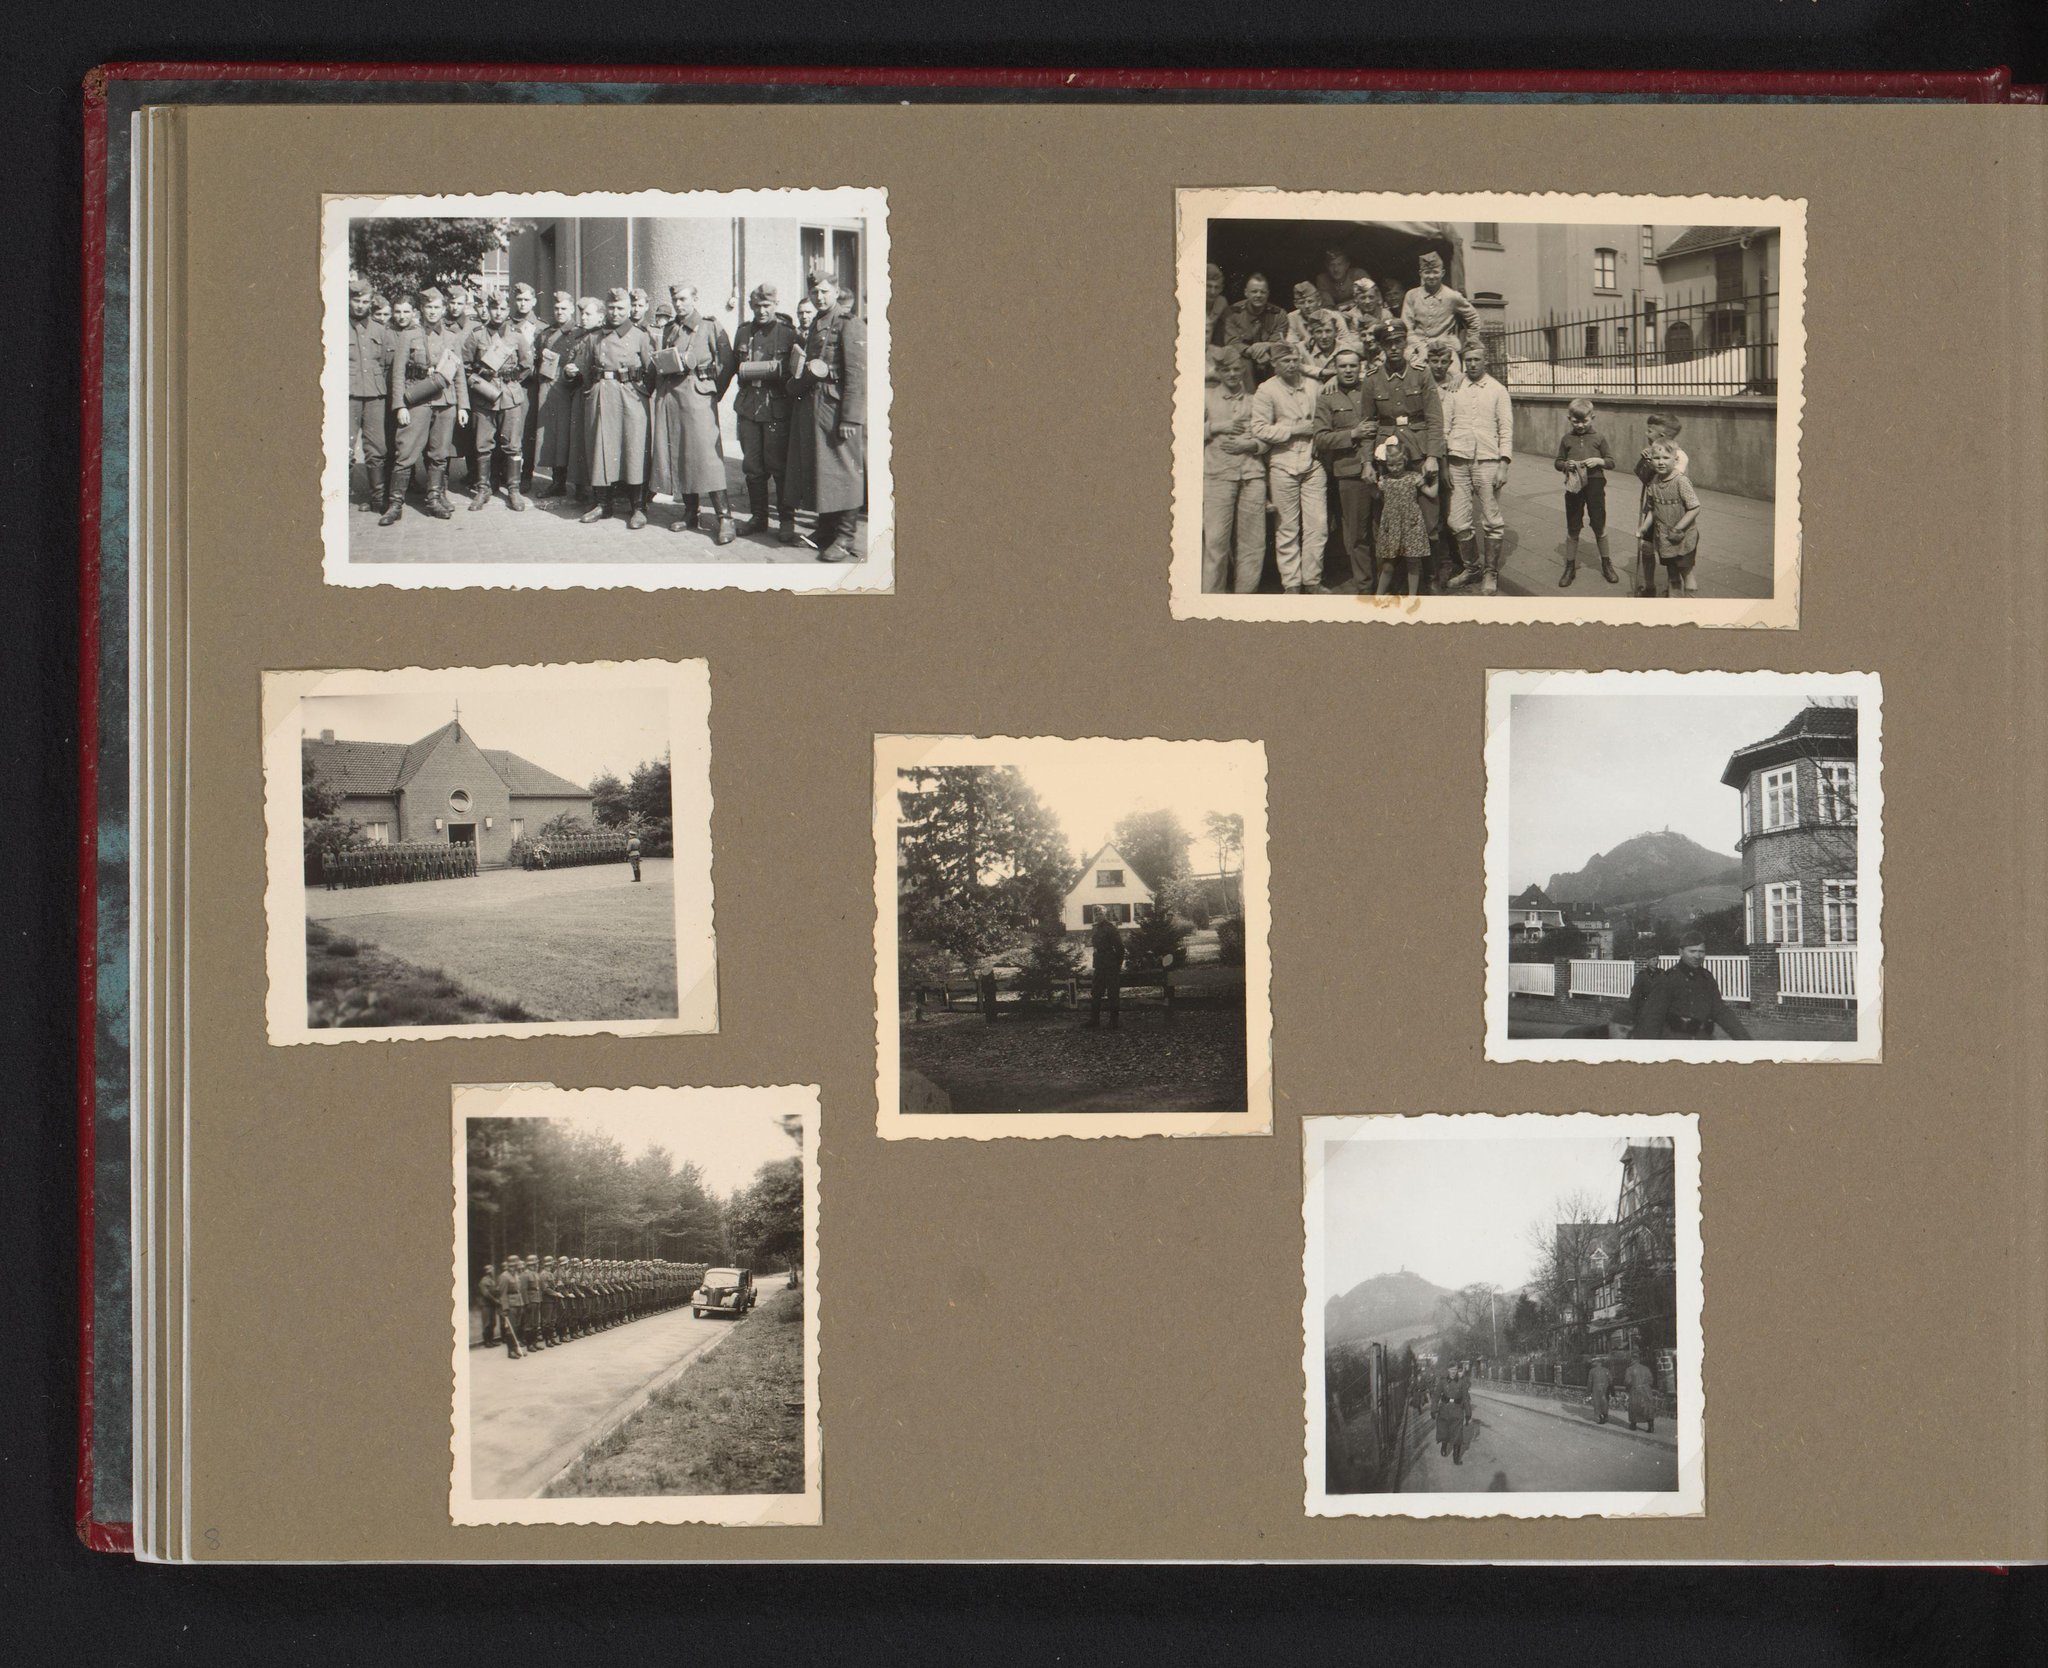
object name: photograph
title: Diverse onderwerpen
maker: Anonymous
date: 1939-1943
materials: paper, photographic support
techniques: gelatin silver print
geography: germany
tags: the company, the unit, the troop ~ military service, review, inspection (of company, unit, troop), military training, germany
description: Albumblad met zeven foto's van groepen soldaten op straat en in het gelid bij inspectie. Onderdeel van het fotoalbum over soldaten van de Wehrmacht, ca. 1939-1943.